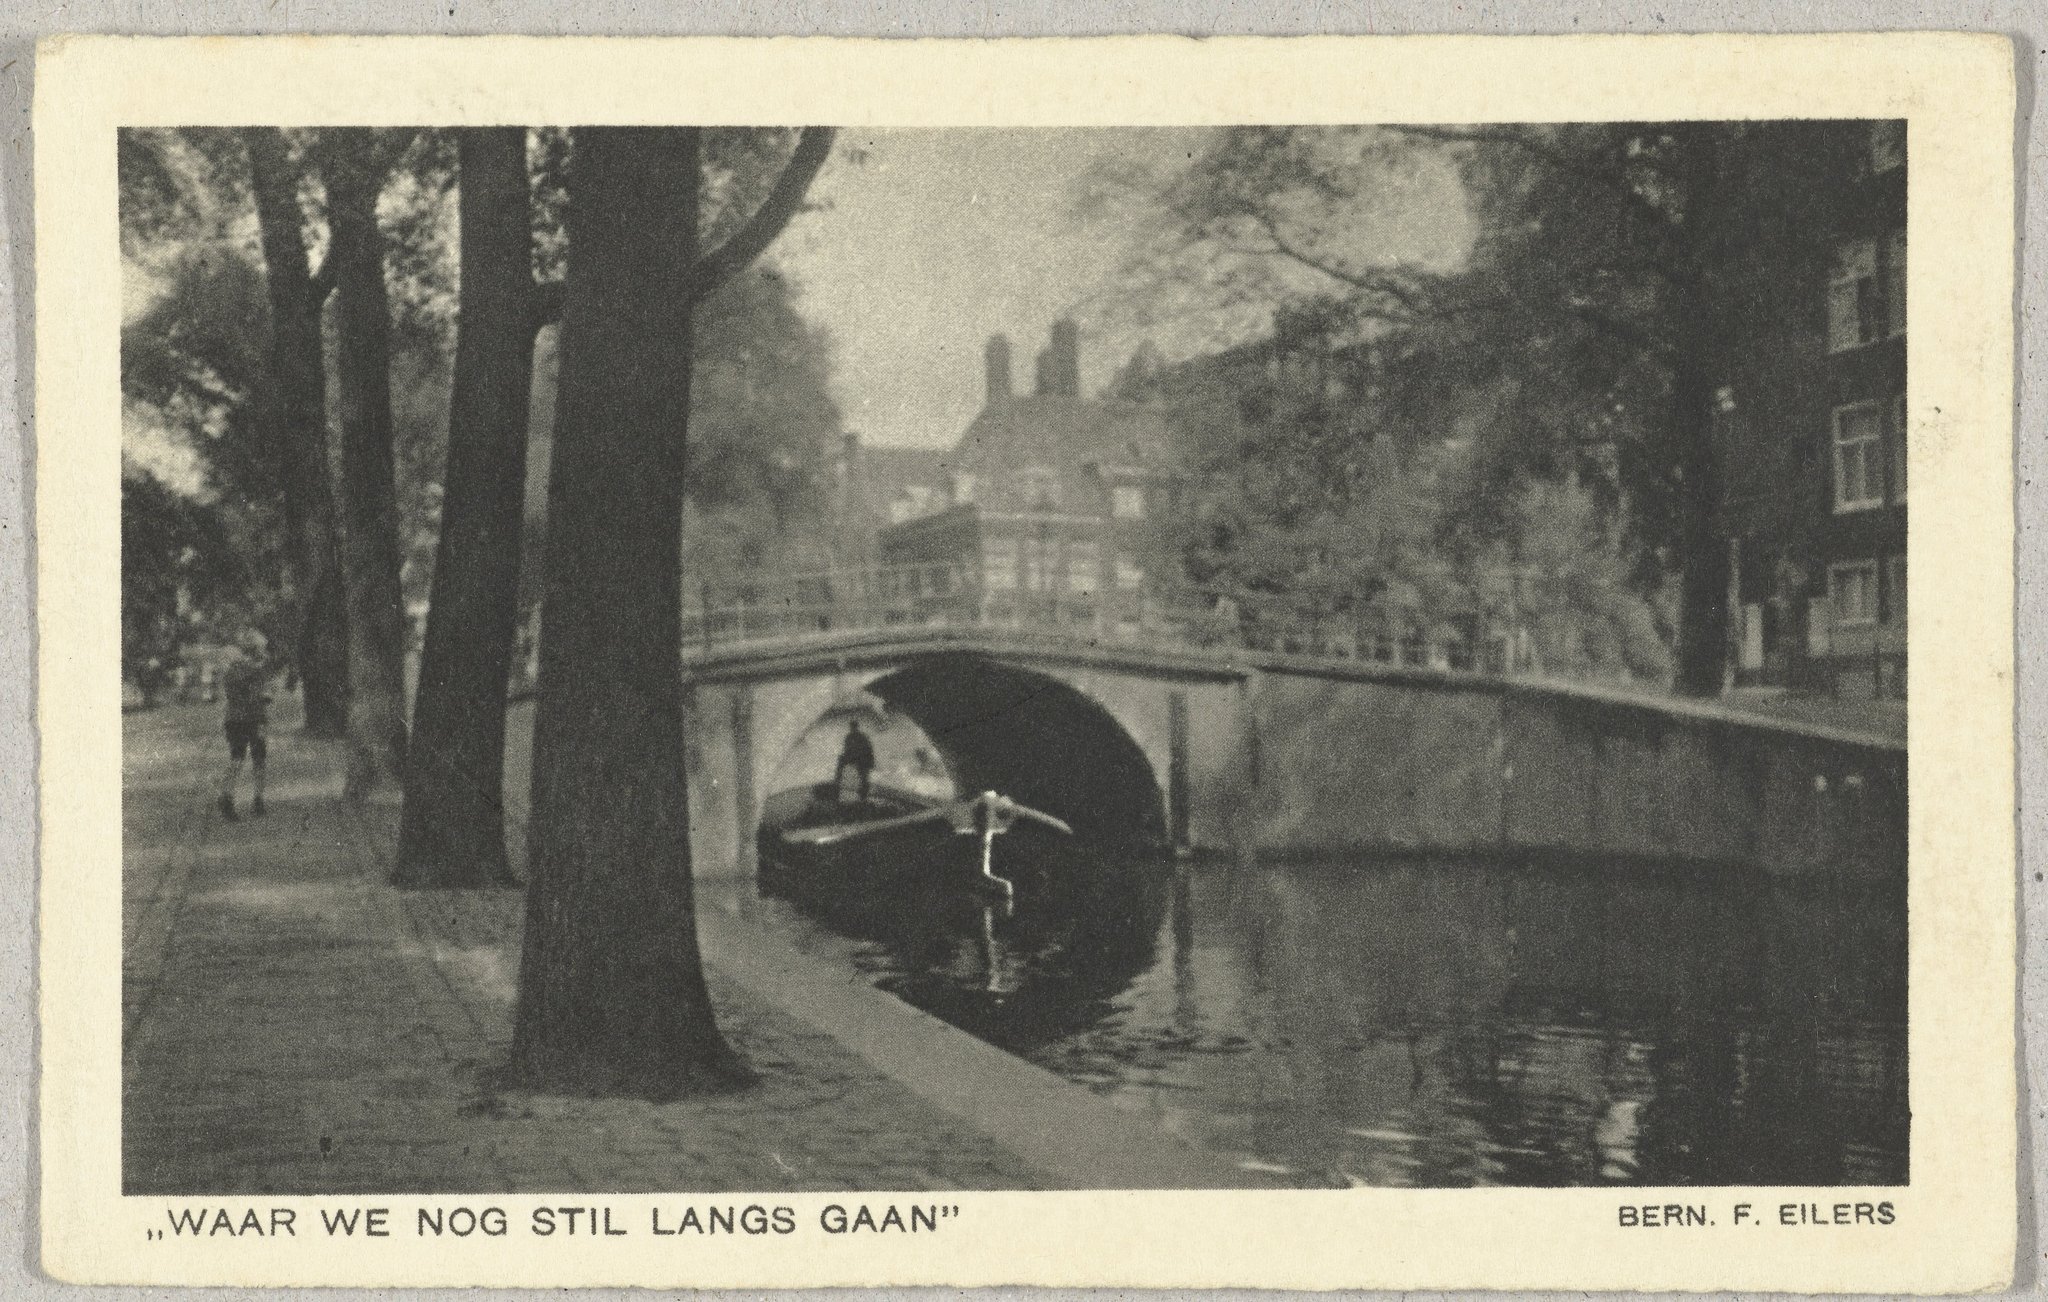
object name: ansichtkaart, prentbriefkaart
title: Reguliersgracht, Amsterdam ("Waar we nog stil langs gaan")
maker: bernard eilers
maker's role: fotograaf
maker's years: 1878-1951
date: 1913-1940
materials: paper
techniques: rotogravure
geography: amsterdam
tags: bridge in city across river, canal, etc.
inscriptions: name: ‘Bern. F. Eilers’, annotation: ‘serie: A, Amsterdam - Reguliersgracht Amsterdam ("Waar we nog stil langs gaan")’, annotation: ‘Eilers Artistieke kaarten - uitg.-mij. "Kosmos" - Amsterdam’